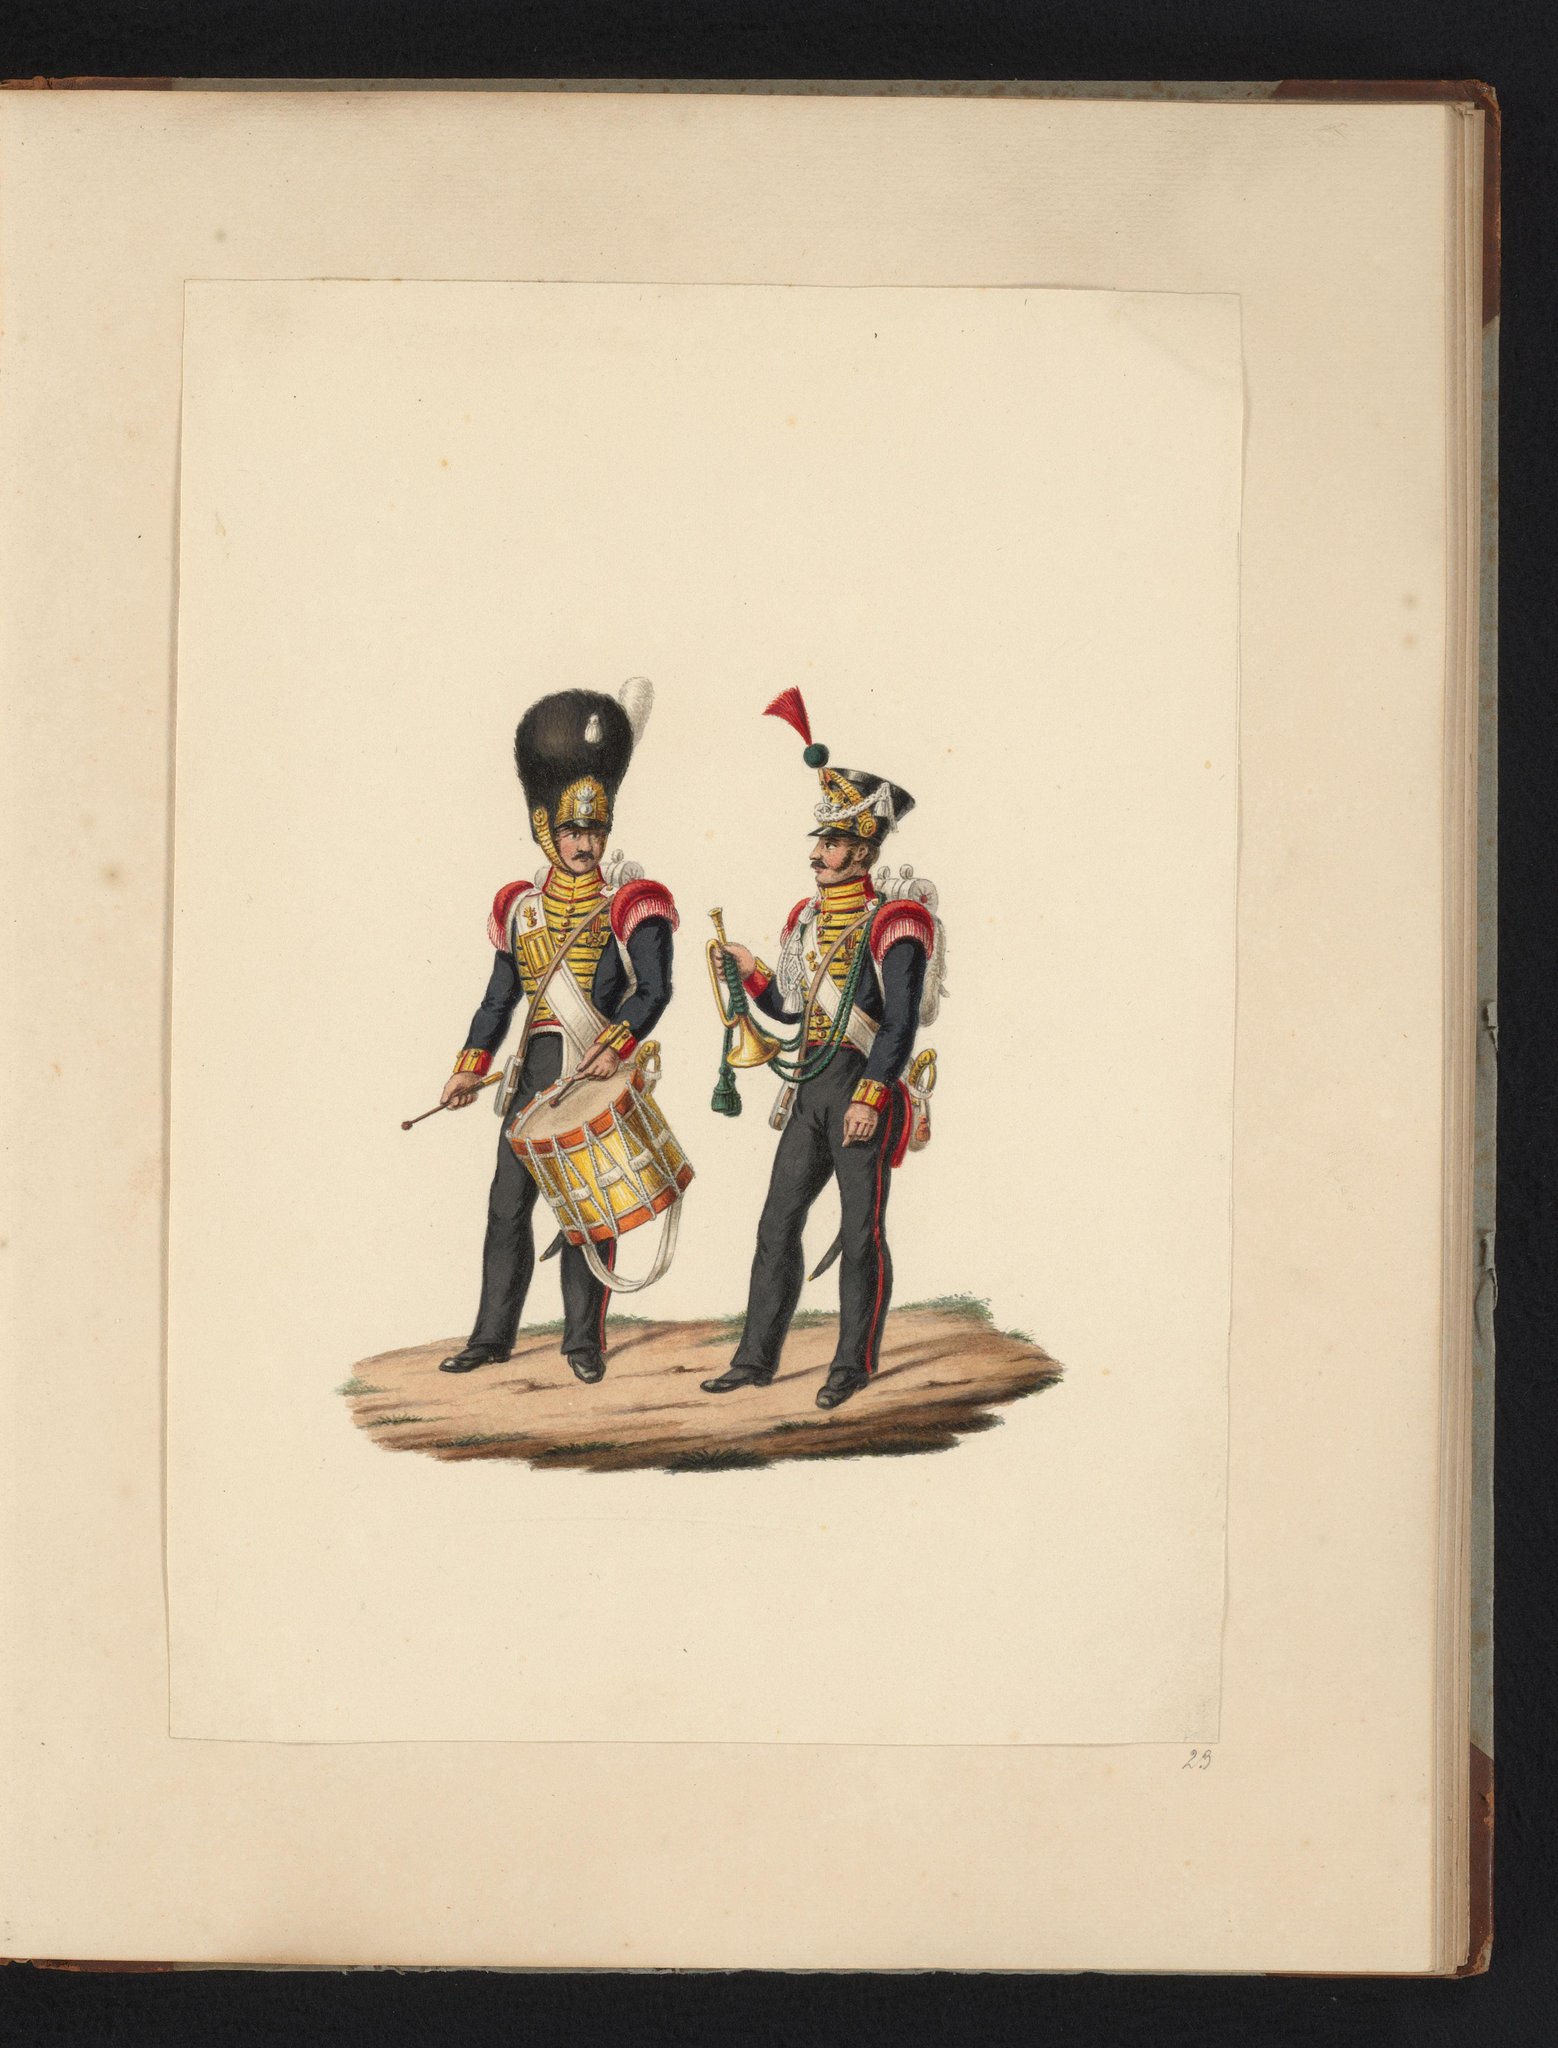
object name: drawing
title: Tamboer en trompetter van de grenadiers, 1830-1831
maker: Anonymous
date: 1831-1832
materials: paper, pencil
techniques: brush, lacquer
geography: netherlands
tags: professional clothes, (military) uniforms, netherlands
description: Een tamboer en een trompetter van de grenadiers, te voet. Onderdeel van het album met 39 ingeplakte tekeningen van militairen van de Koninklijke Nederlandsche Armee uit 1830-1831.